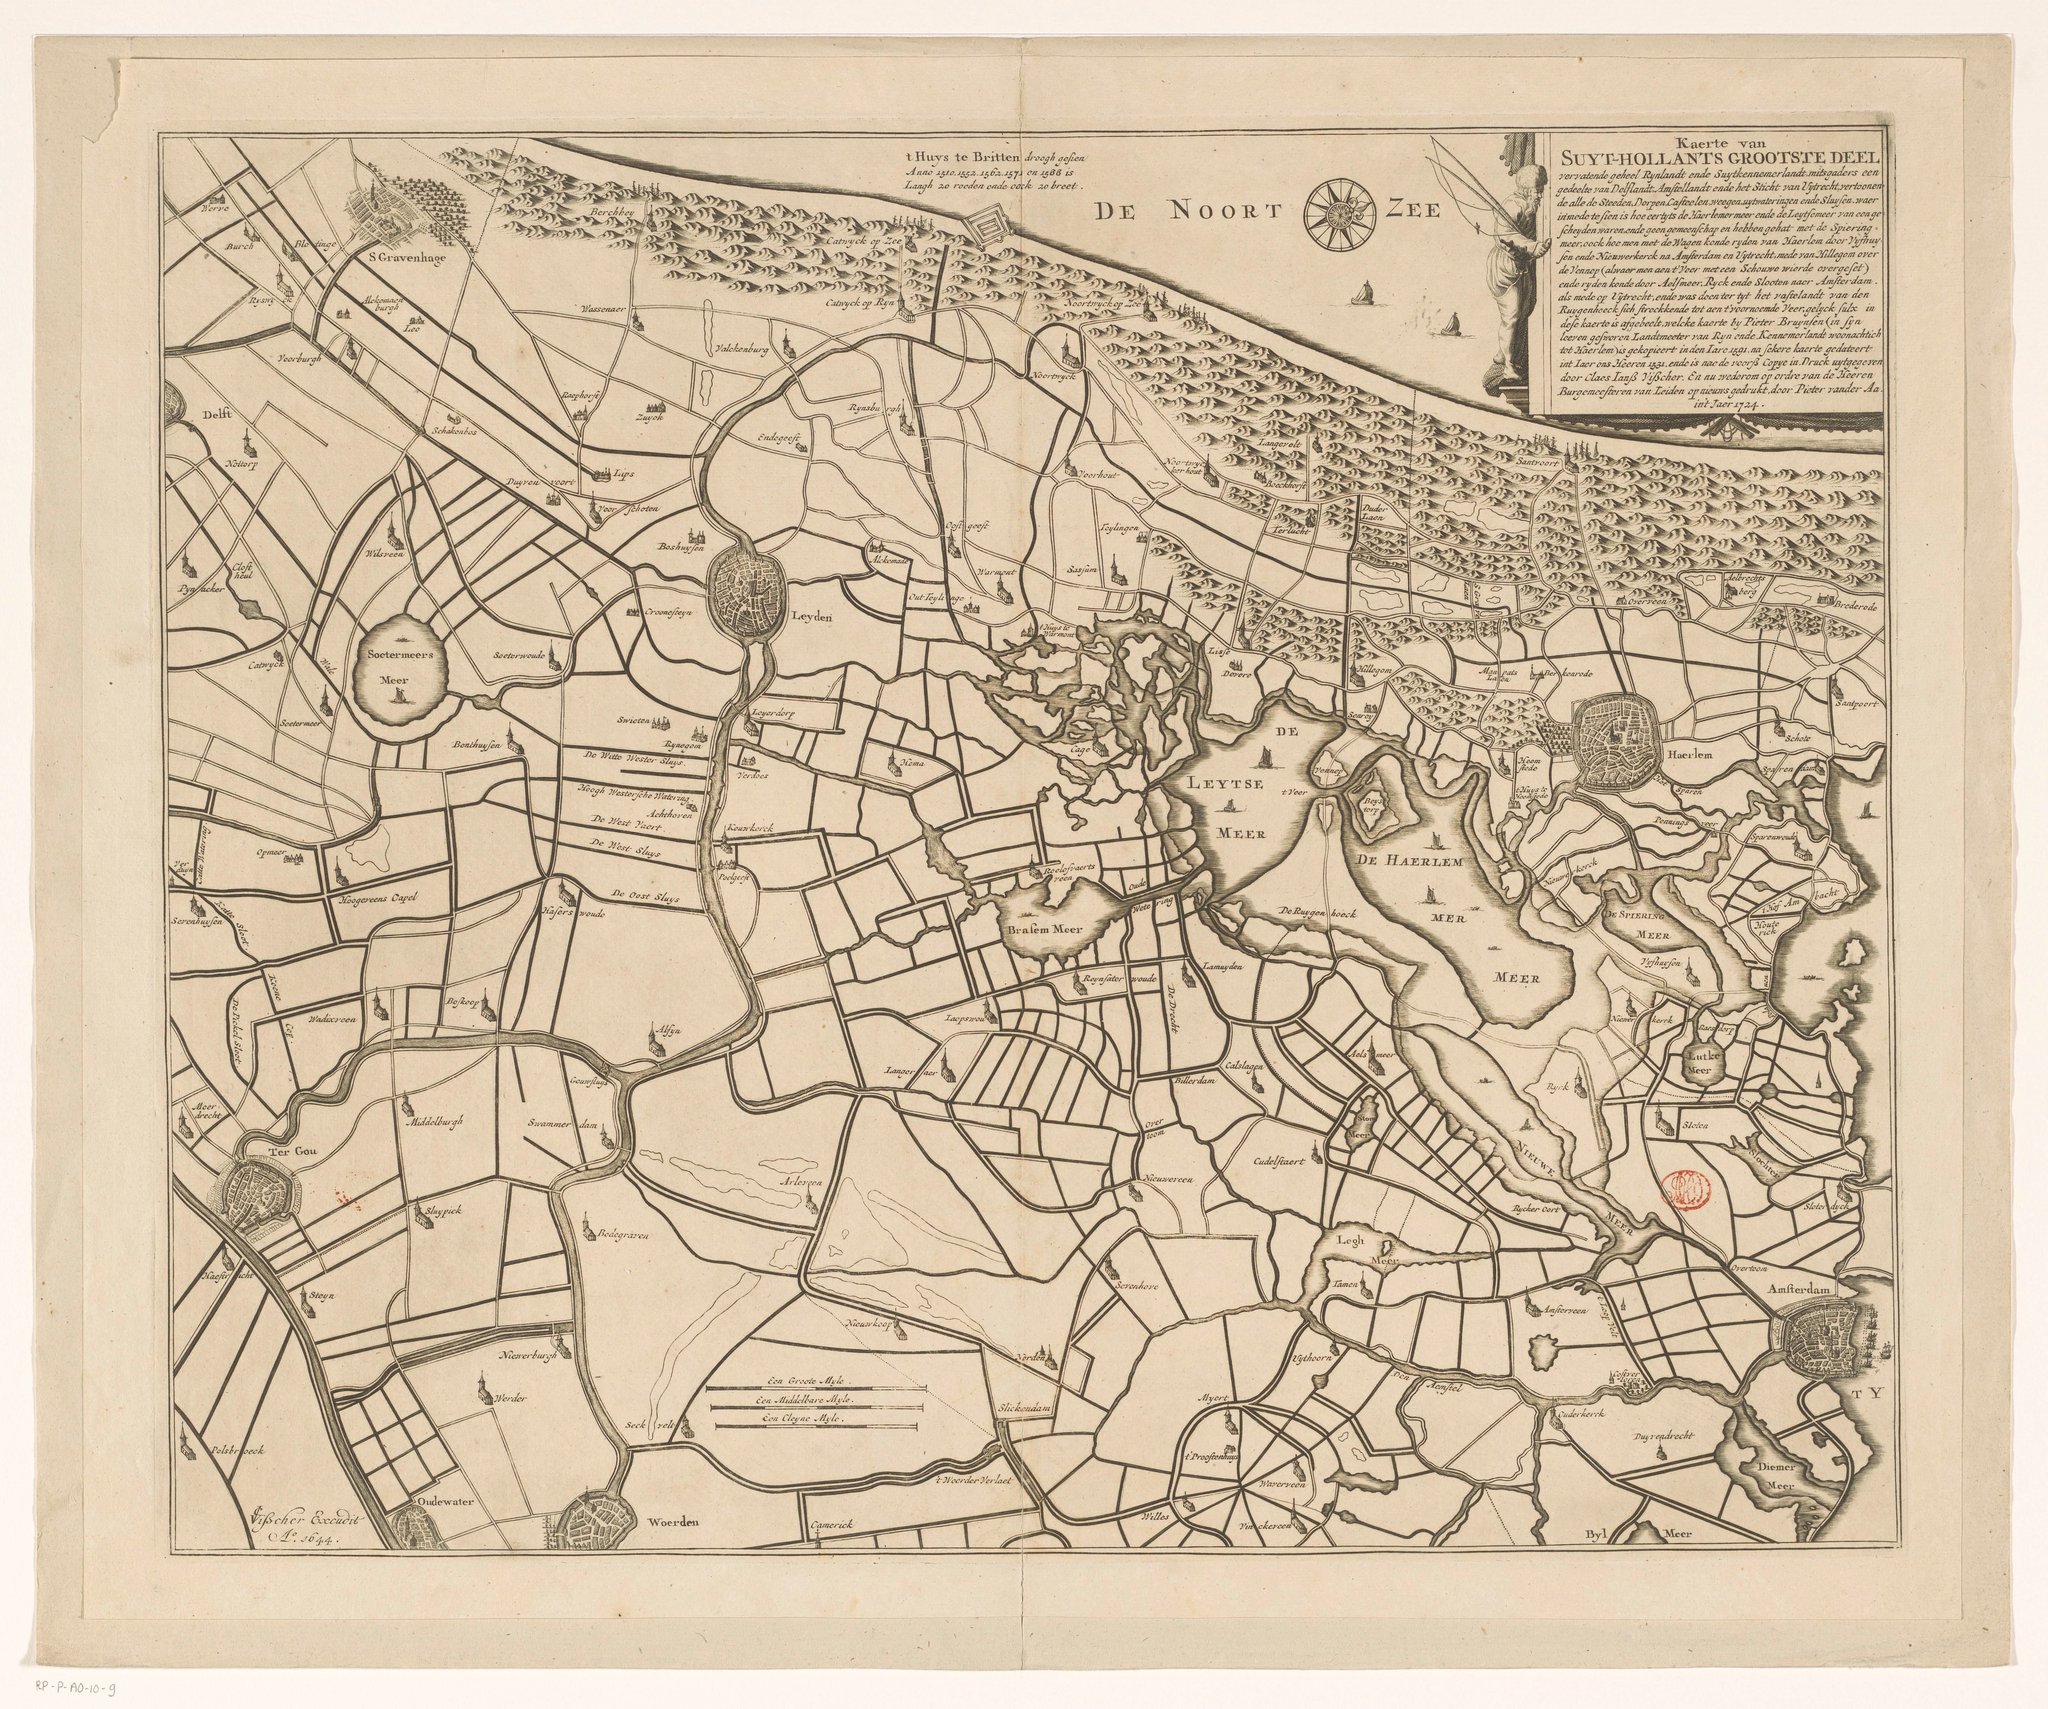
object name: print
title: Historische kaart van een deel van Zuid- en Noord-Holland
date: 1644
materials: paper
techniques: engraving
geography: leiden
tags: maps of separate countries or regions, utrecht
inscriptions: collector's mark: Lugt 195